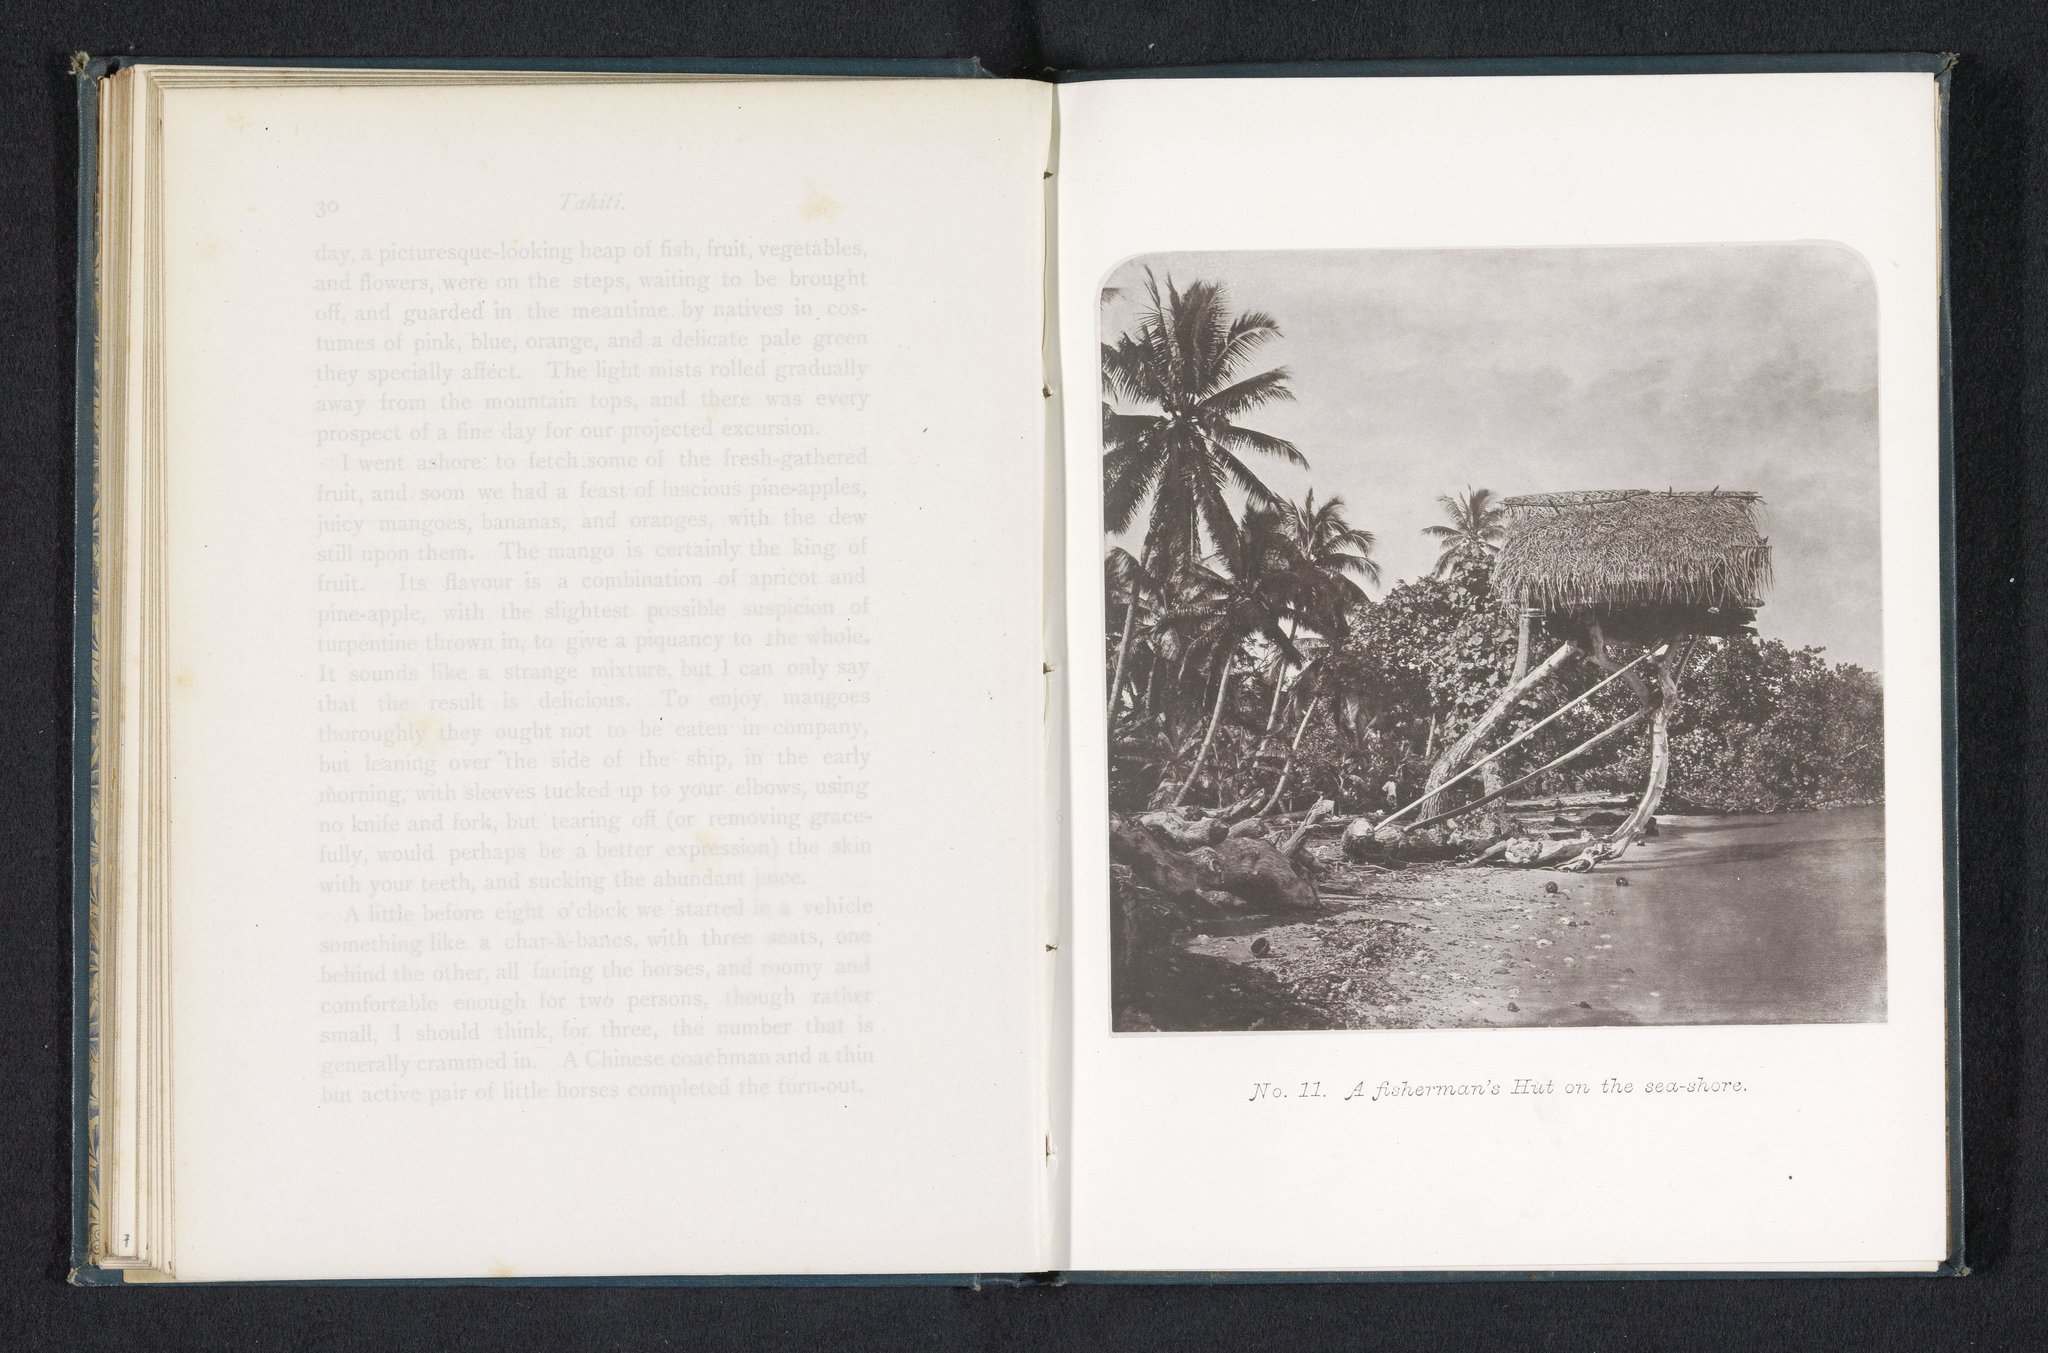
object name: page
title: Woning van een visser op Tahiti, deels gebouwd boven de Stille Oceaan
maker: henry stuart-wortley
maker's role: fotograaf, kolonel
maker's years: 1832-1890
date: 1880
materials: paper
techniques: photograph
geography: tahiti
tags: ocean, hut, cabin, lodge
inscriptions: number: ‘No. 11.’